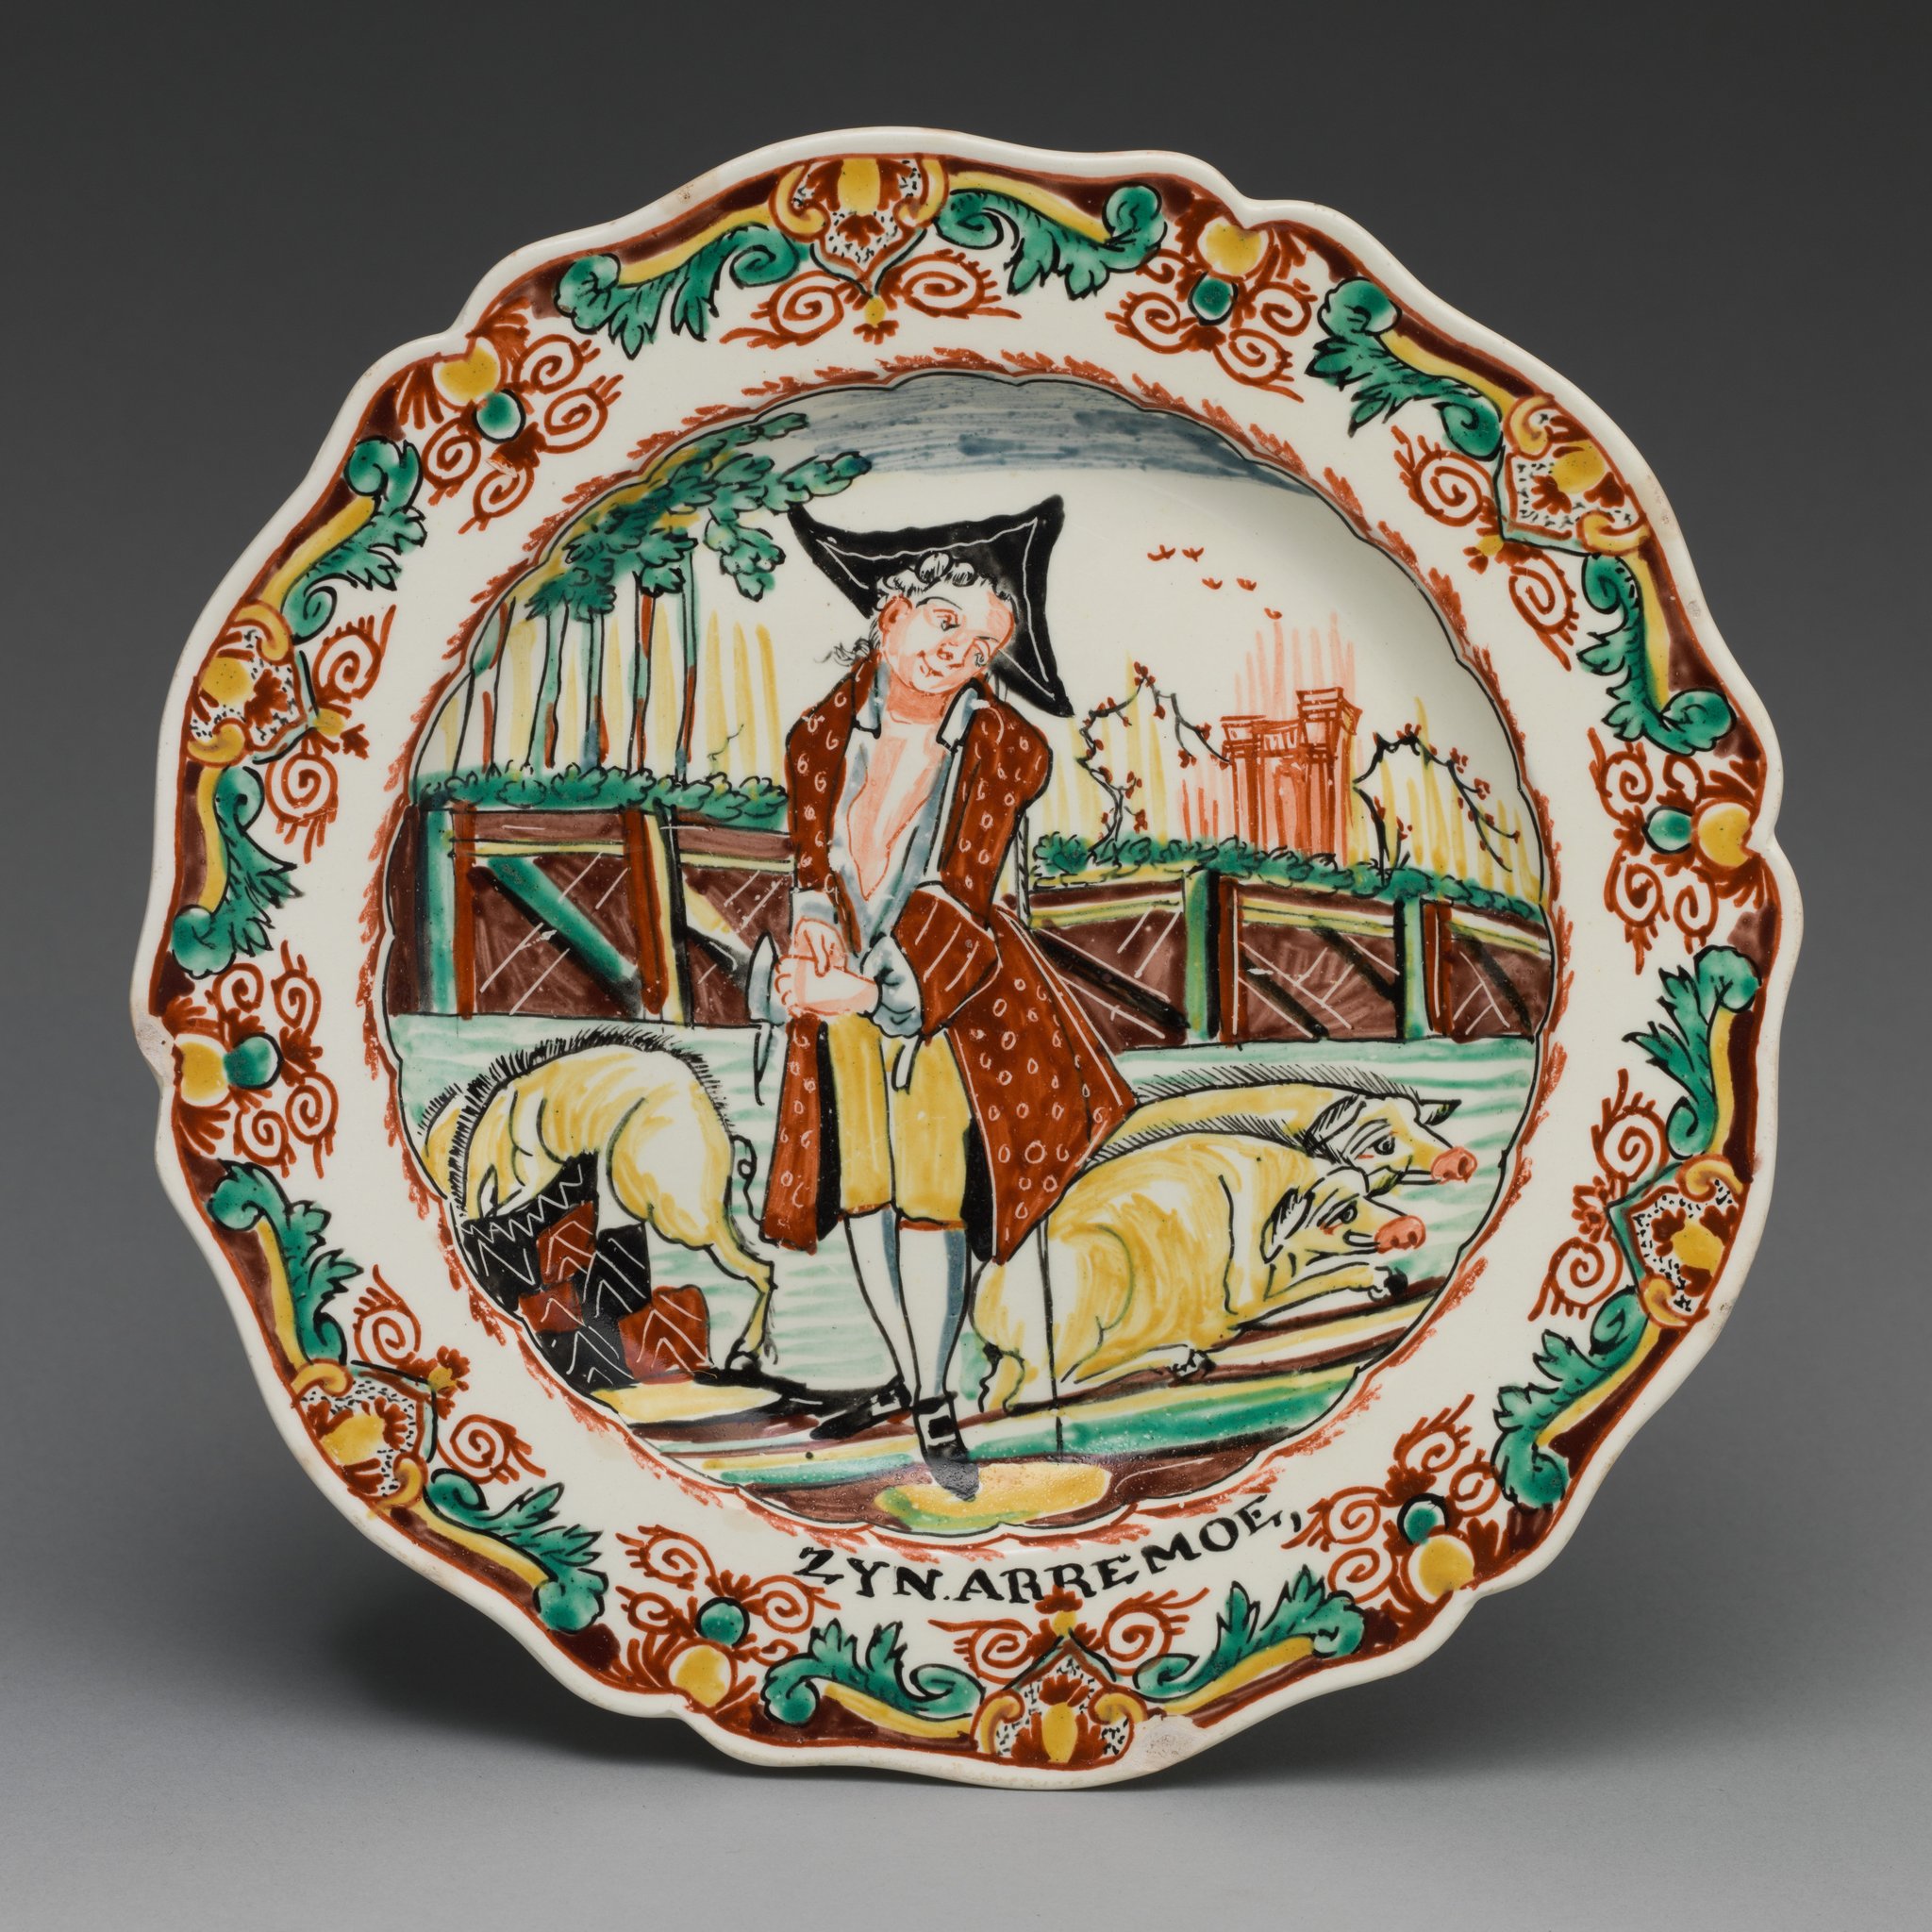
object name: plate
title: Plate (part of a set of six)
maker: john turner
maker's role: maker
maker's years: 1762-1786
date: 1790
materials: earthenware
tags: men,pigs